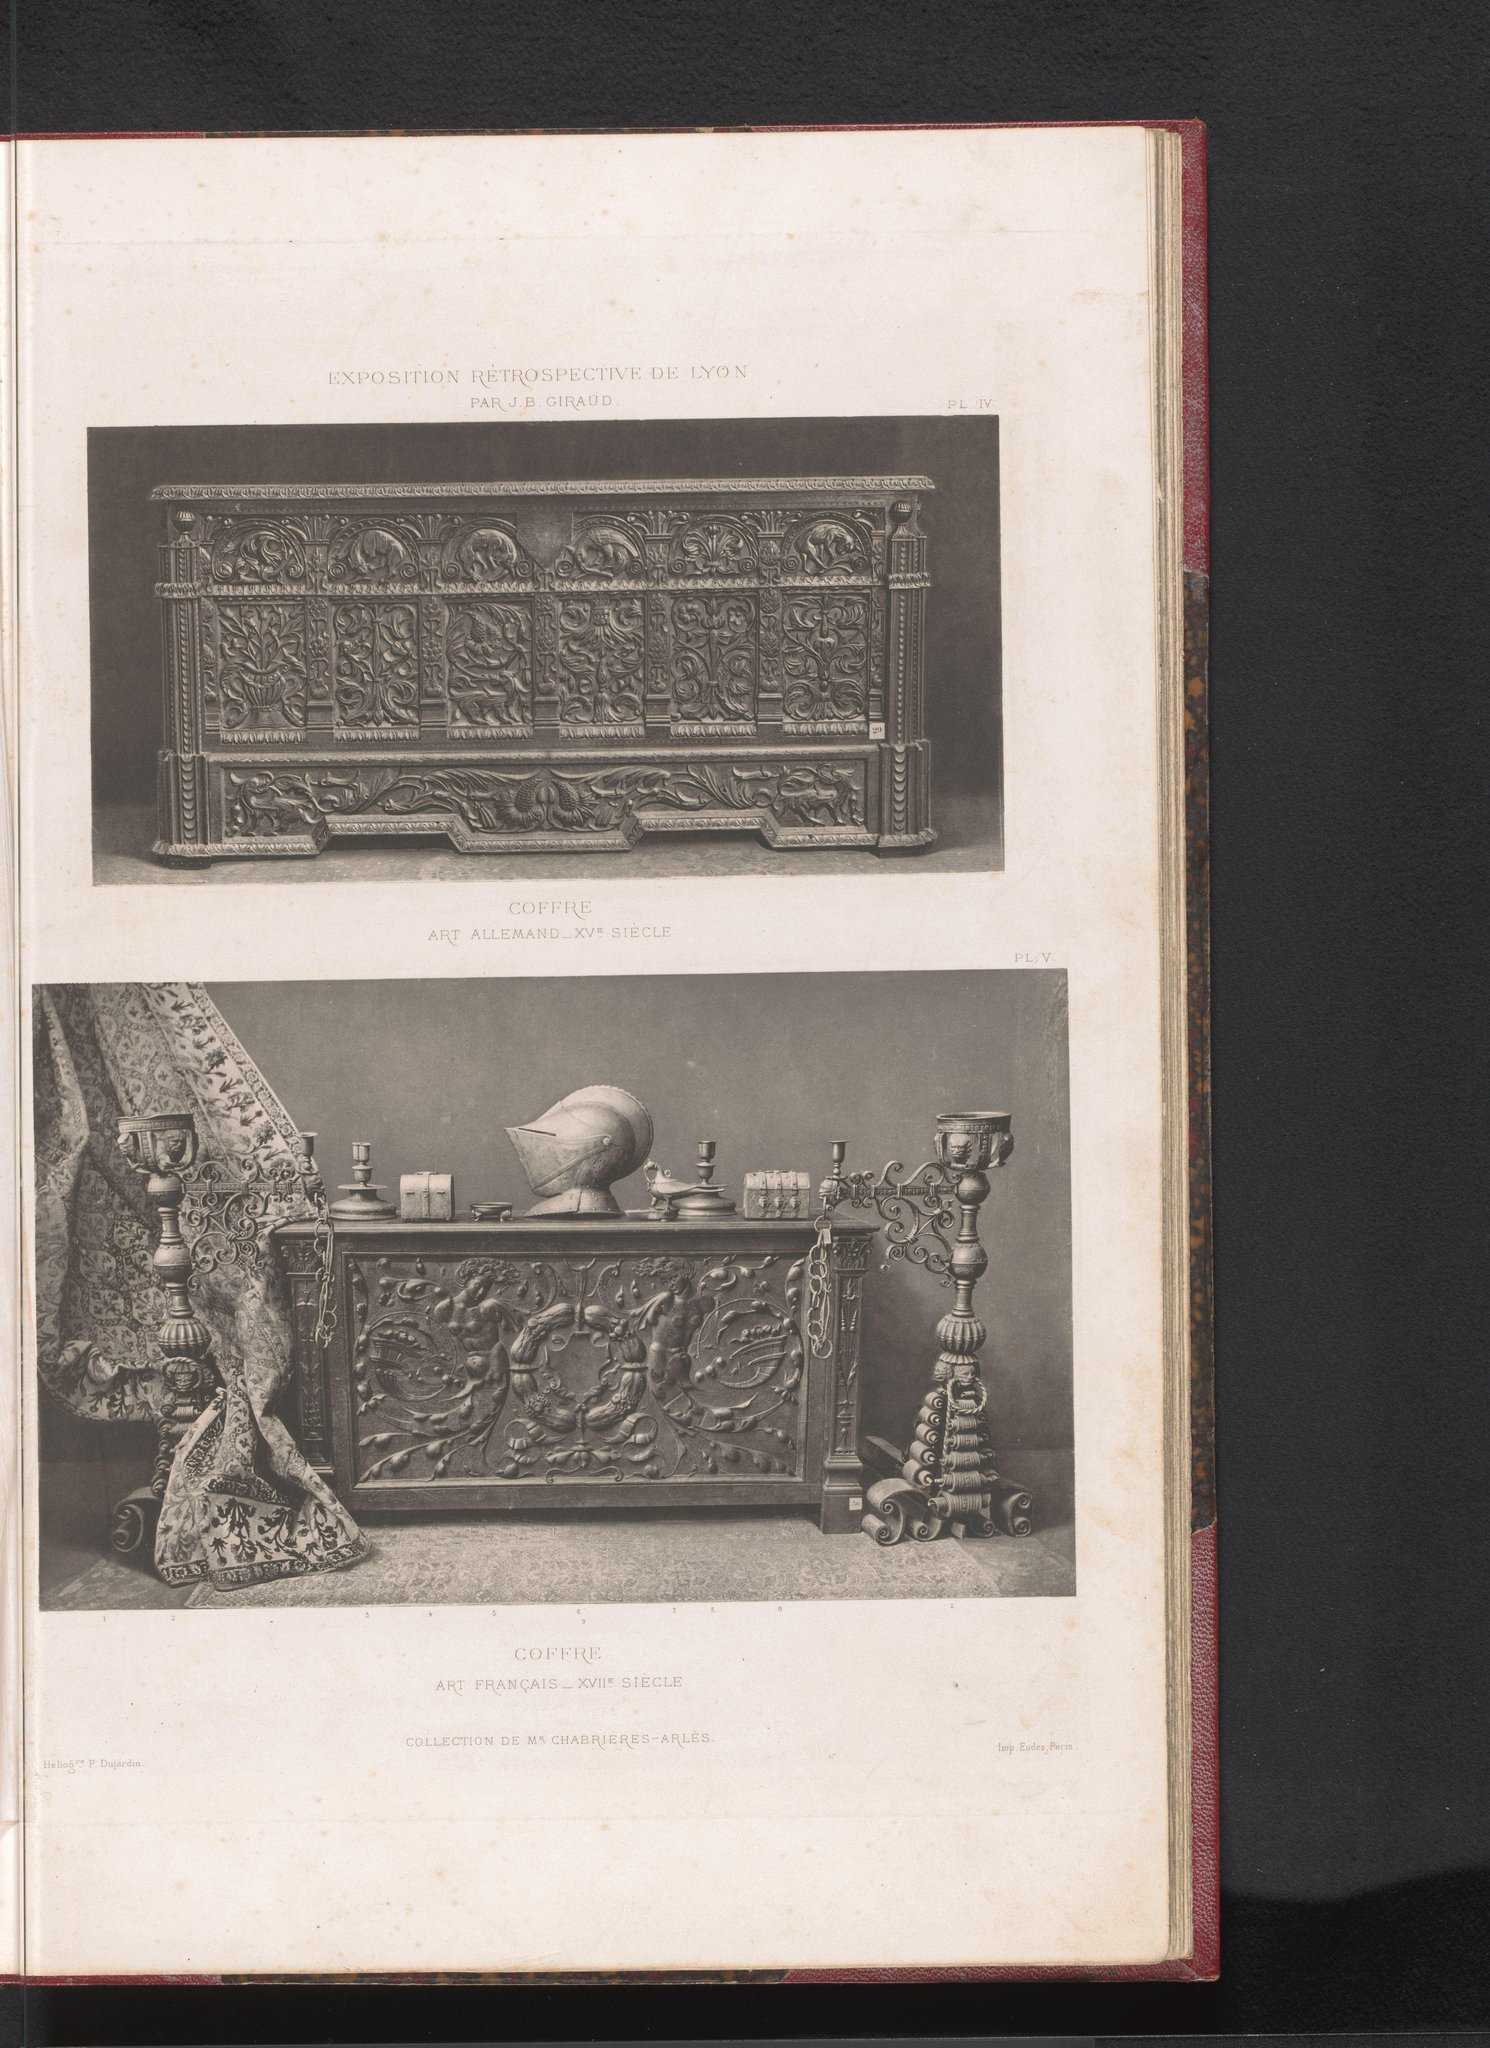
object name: photomechanical print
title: 15de-eeuwse Duitse koffer van hout en een 17de-eeuwse Franse koffer van hout, op de Exposition Rétrospective van 1877 in Lyon, Frankrijk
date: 1877-1880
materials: paper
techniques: photoaquatint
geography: lyon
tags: chest, coffer (+ wood and other phytogenic material), lyon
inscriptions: inscription: ‘EXPOSITION RÉTROSPECTIVE DE LYON/ PAR J. B. GIRAUD.’, inscription: ‘COFFRE/ ART ALLEMAND_XVe SIÈCLE’, number: ‘PL. V.’, inscription: ‘COFFRE/ ART FRANÇAIS_XVIIe SIÈCLE/ COLLECTION DE Mr CHABRIÈRES-ARLÈS.’, number: ‘PL. IV.’